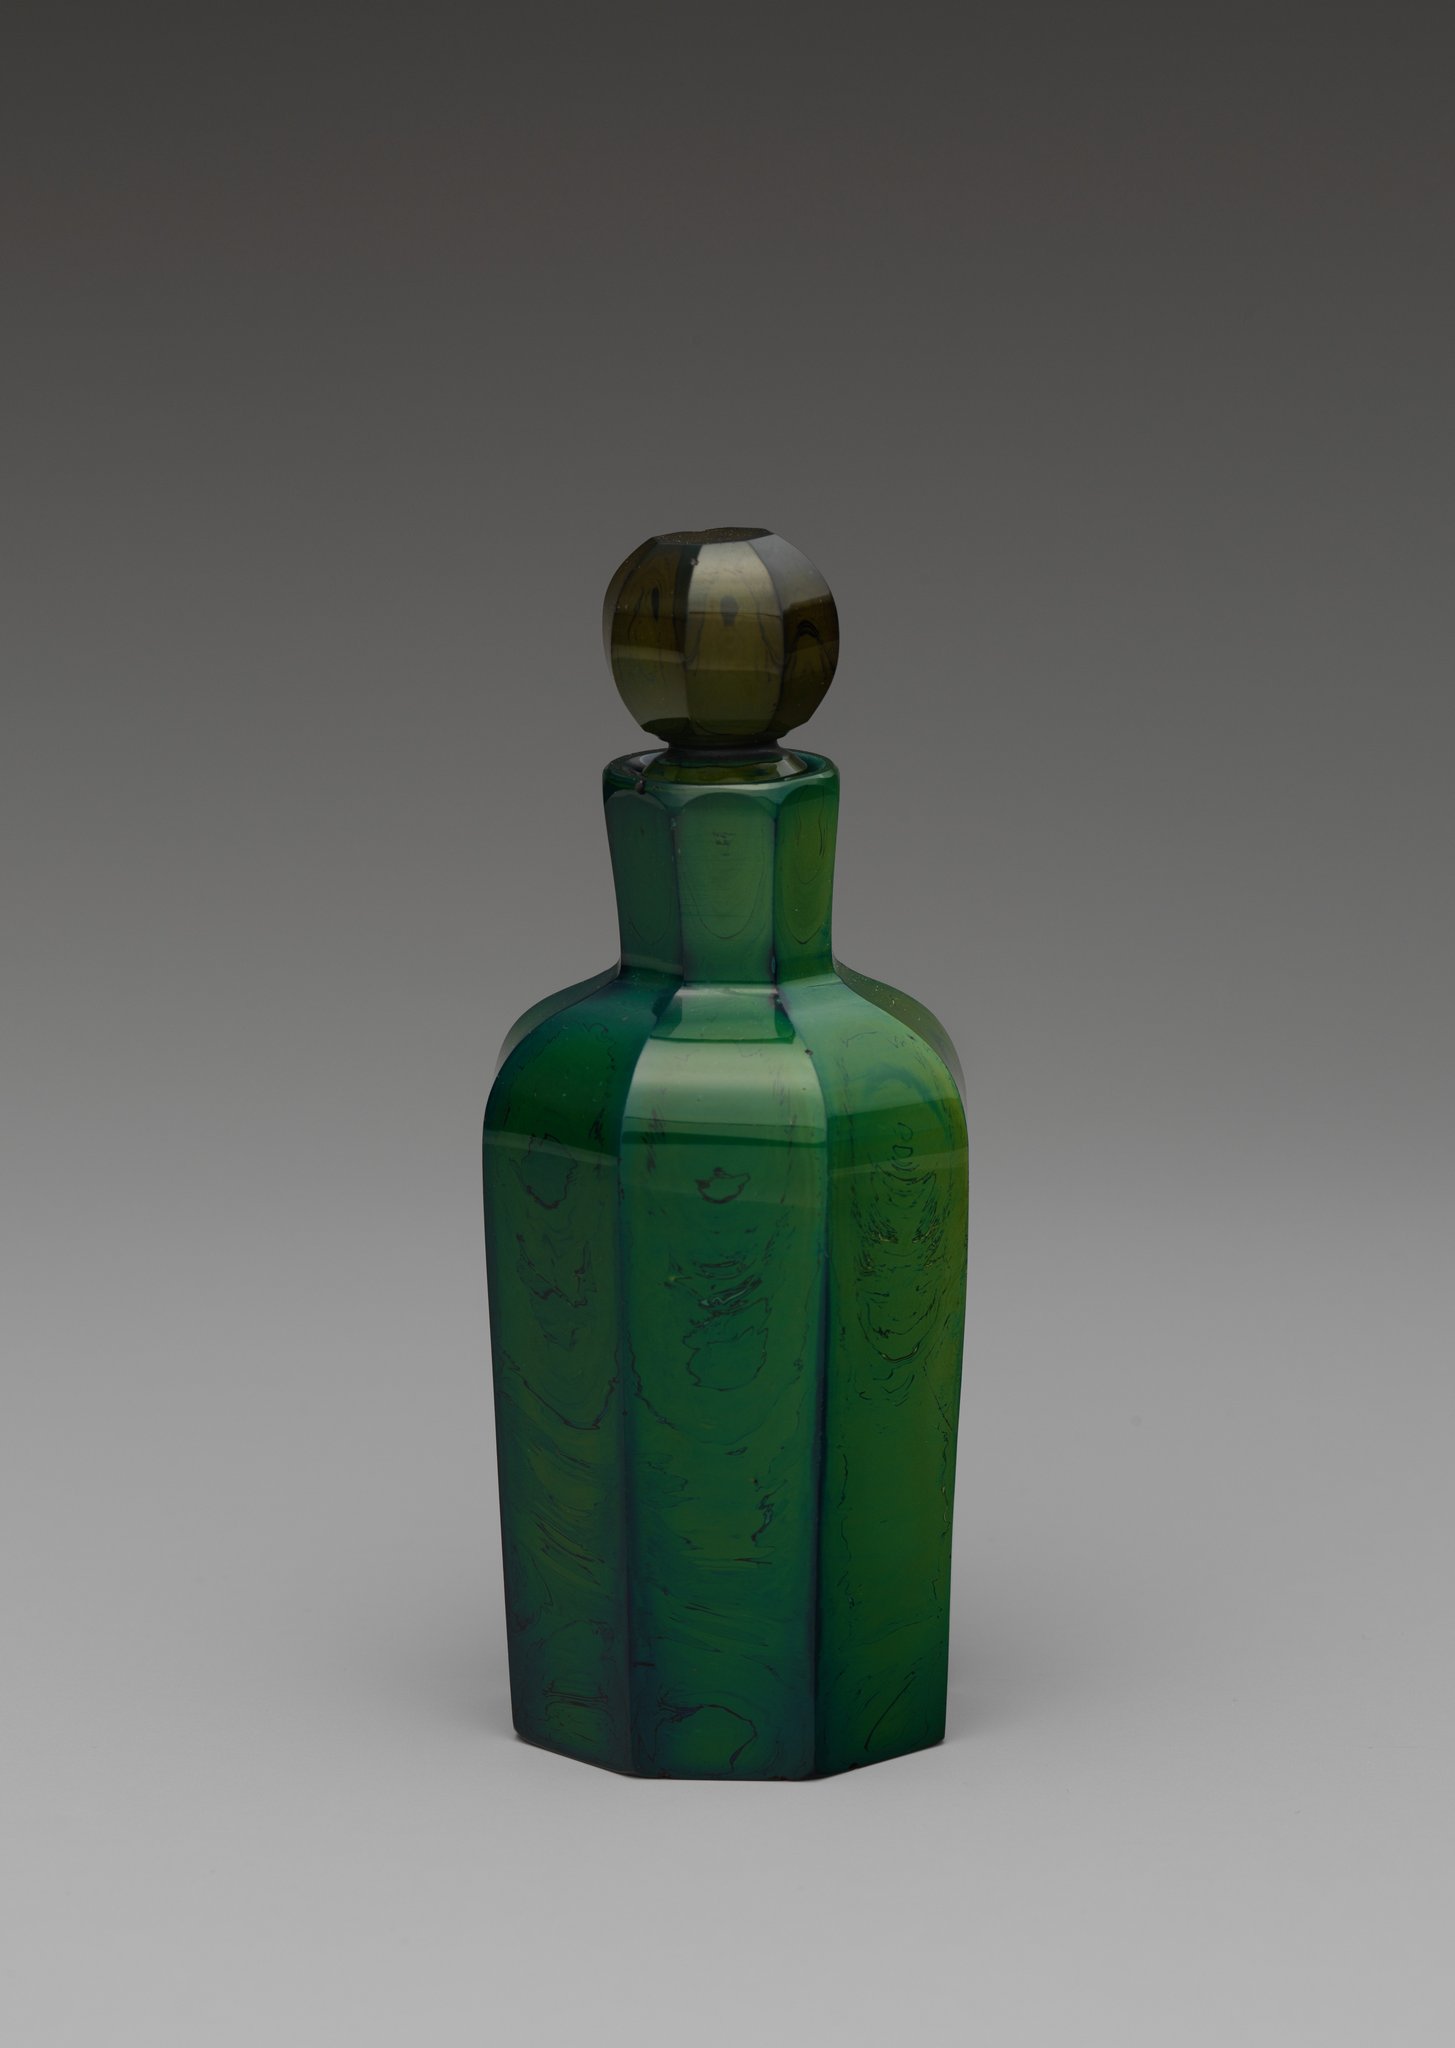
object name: bottle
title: Fluted Bottle with Stopper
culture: chinese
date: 1801-1833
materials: glass